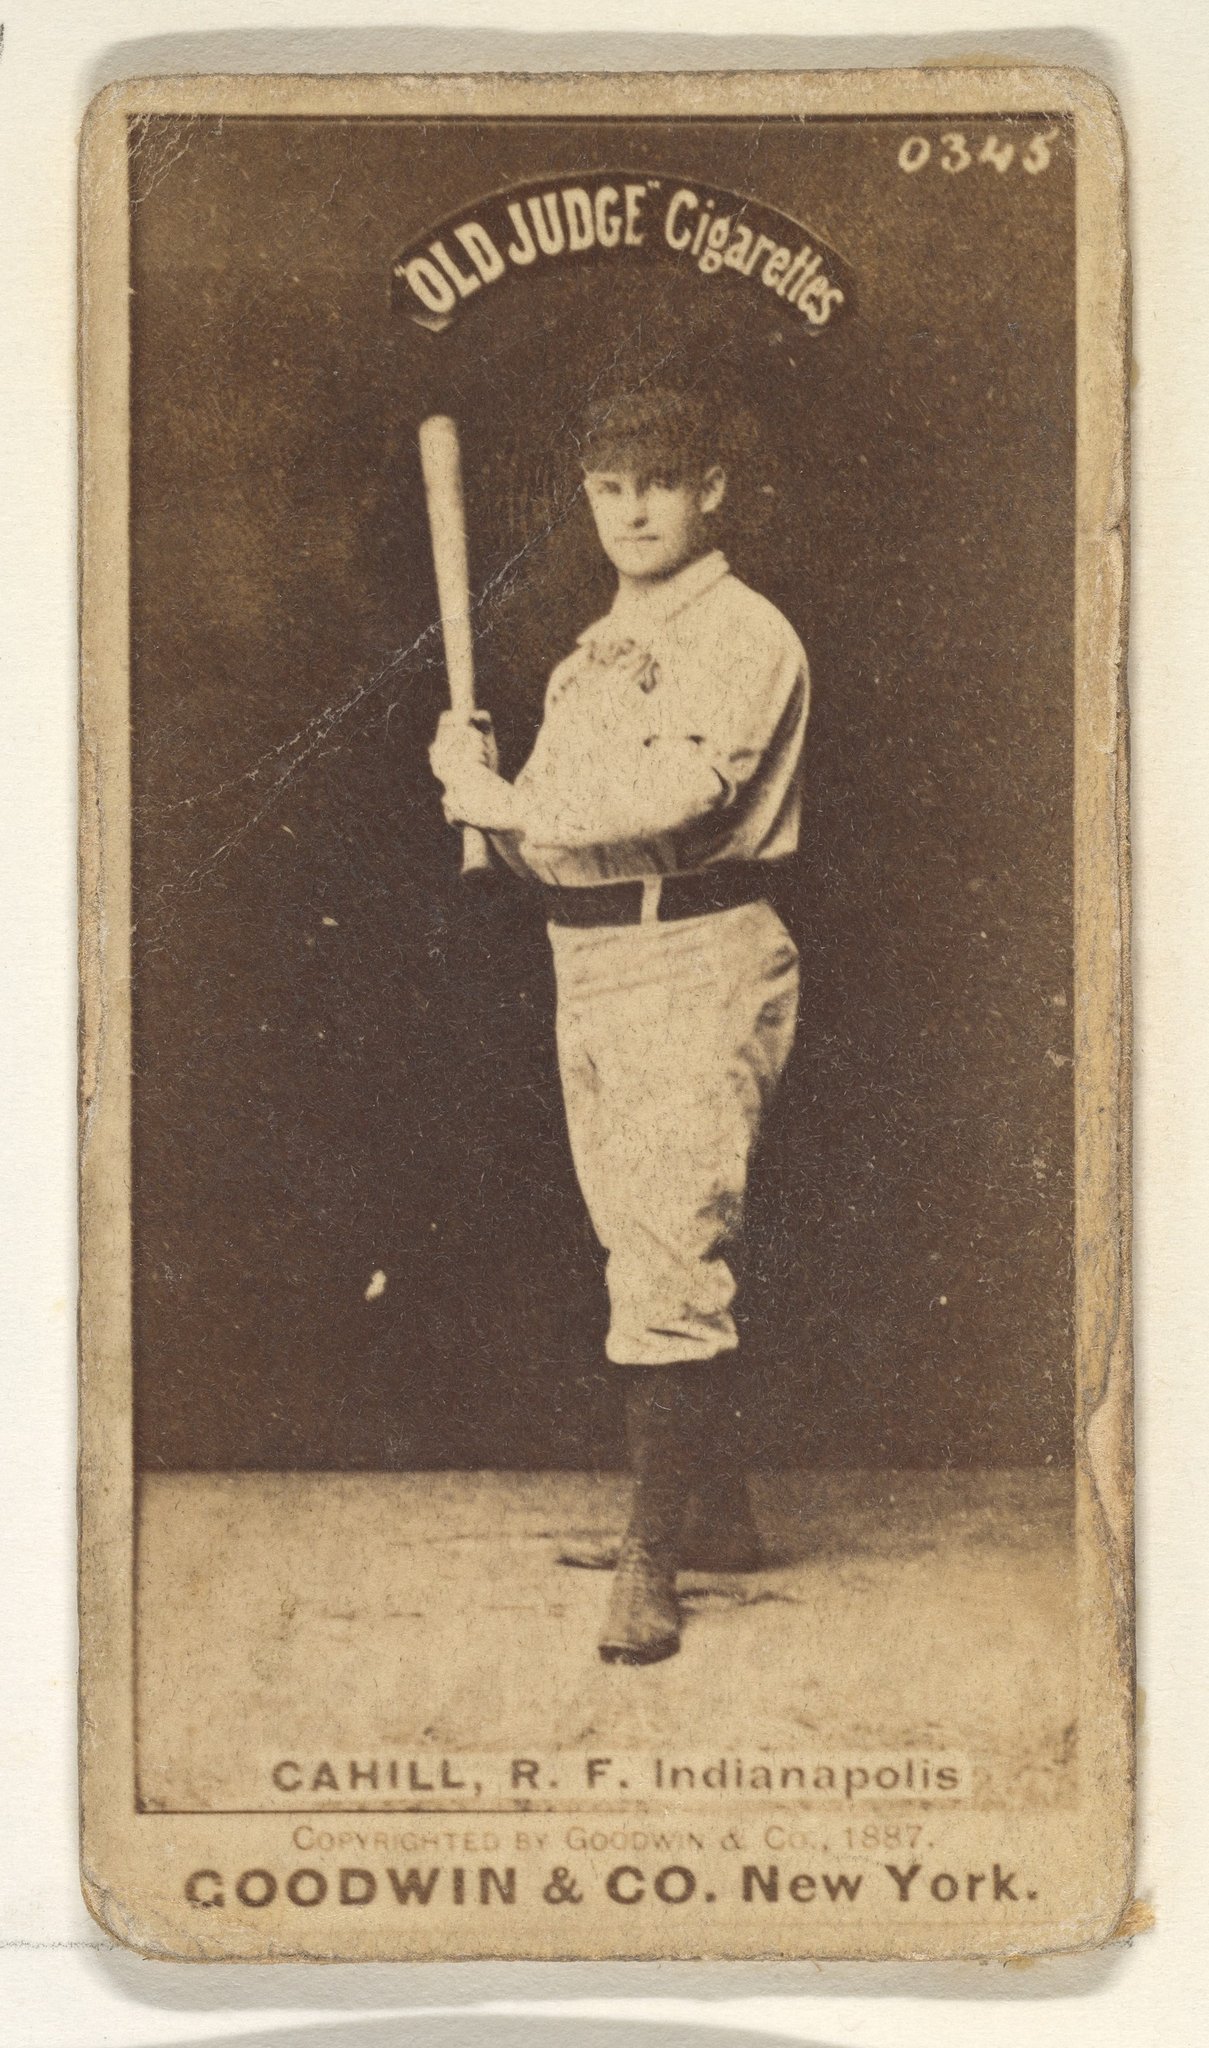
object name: baseball card, photograph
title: Cahill, Right Field, Indianapolis, from the Old Judge series (N172) for Old Judge Cigarettes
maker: goodwin & company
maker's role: publisher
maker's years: 1850-1950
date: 1887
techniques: albumen silver print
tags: men,portraits,baseball,athletes